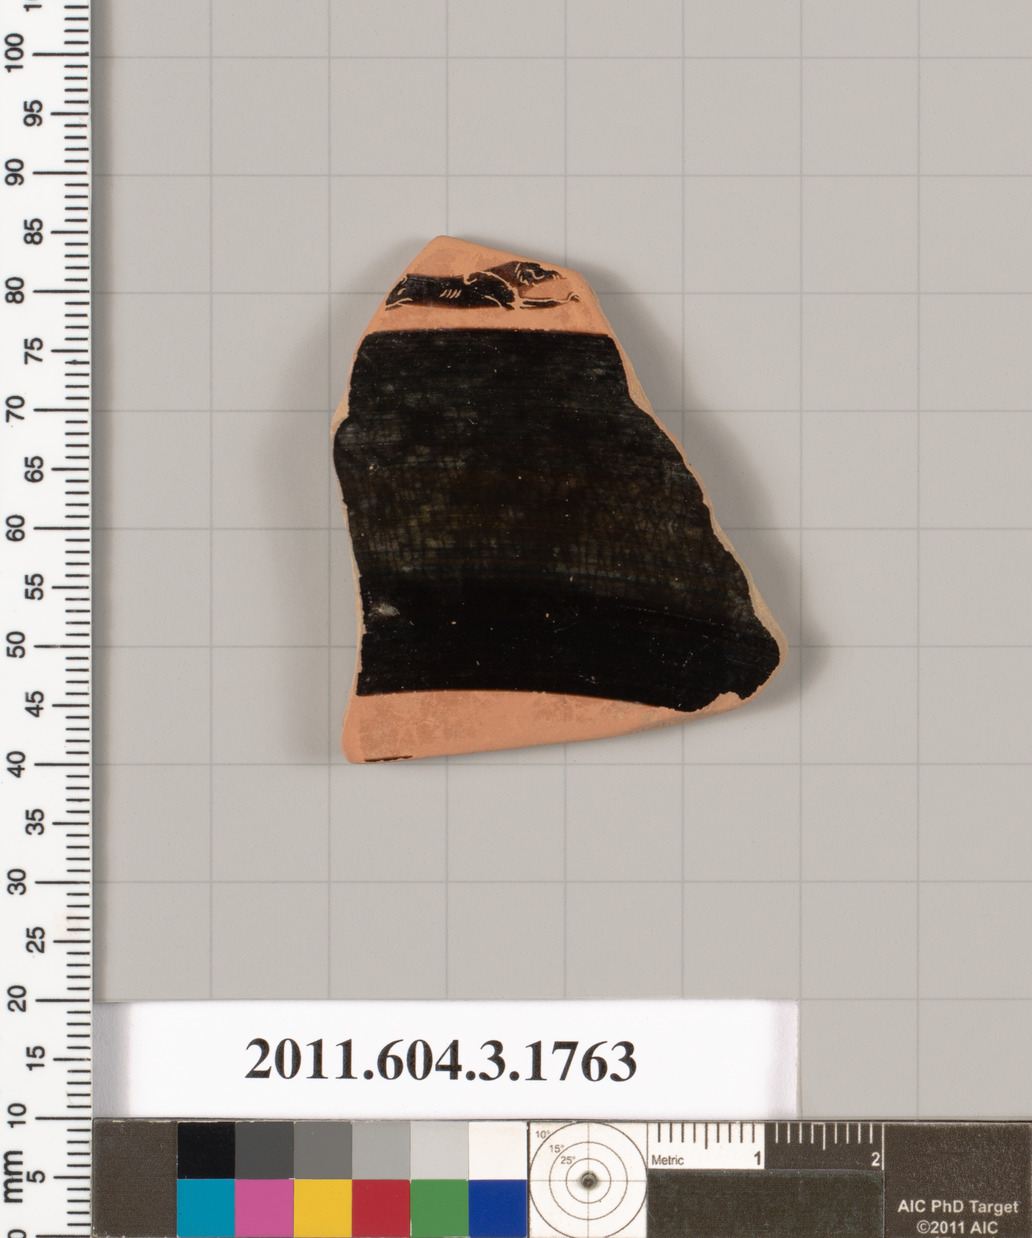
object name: kylix fragment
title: Terracotta fragment of a kylix: Band cup (drinking cup)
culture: greek, attic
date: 567-535 BCE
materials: terracotta